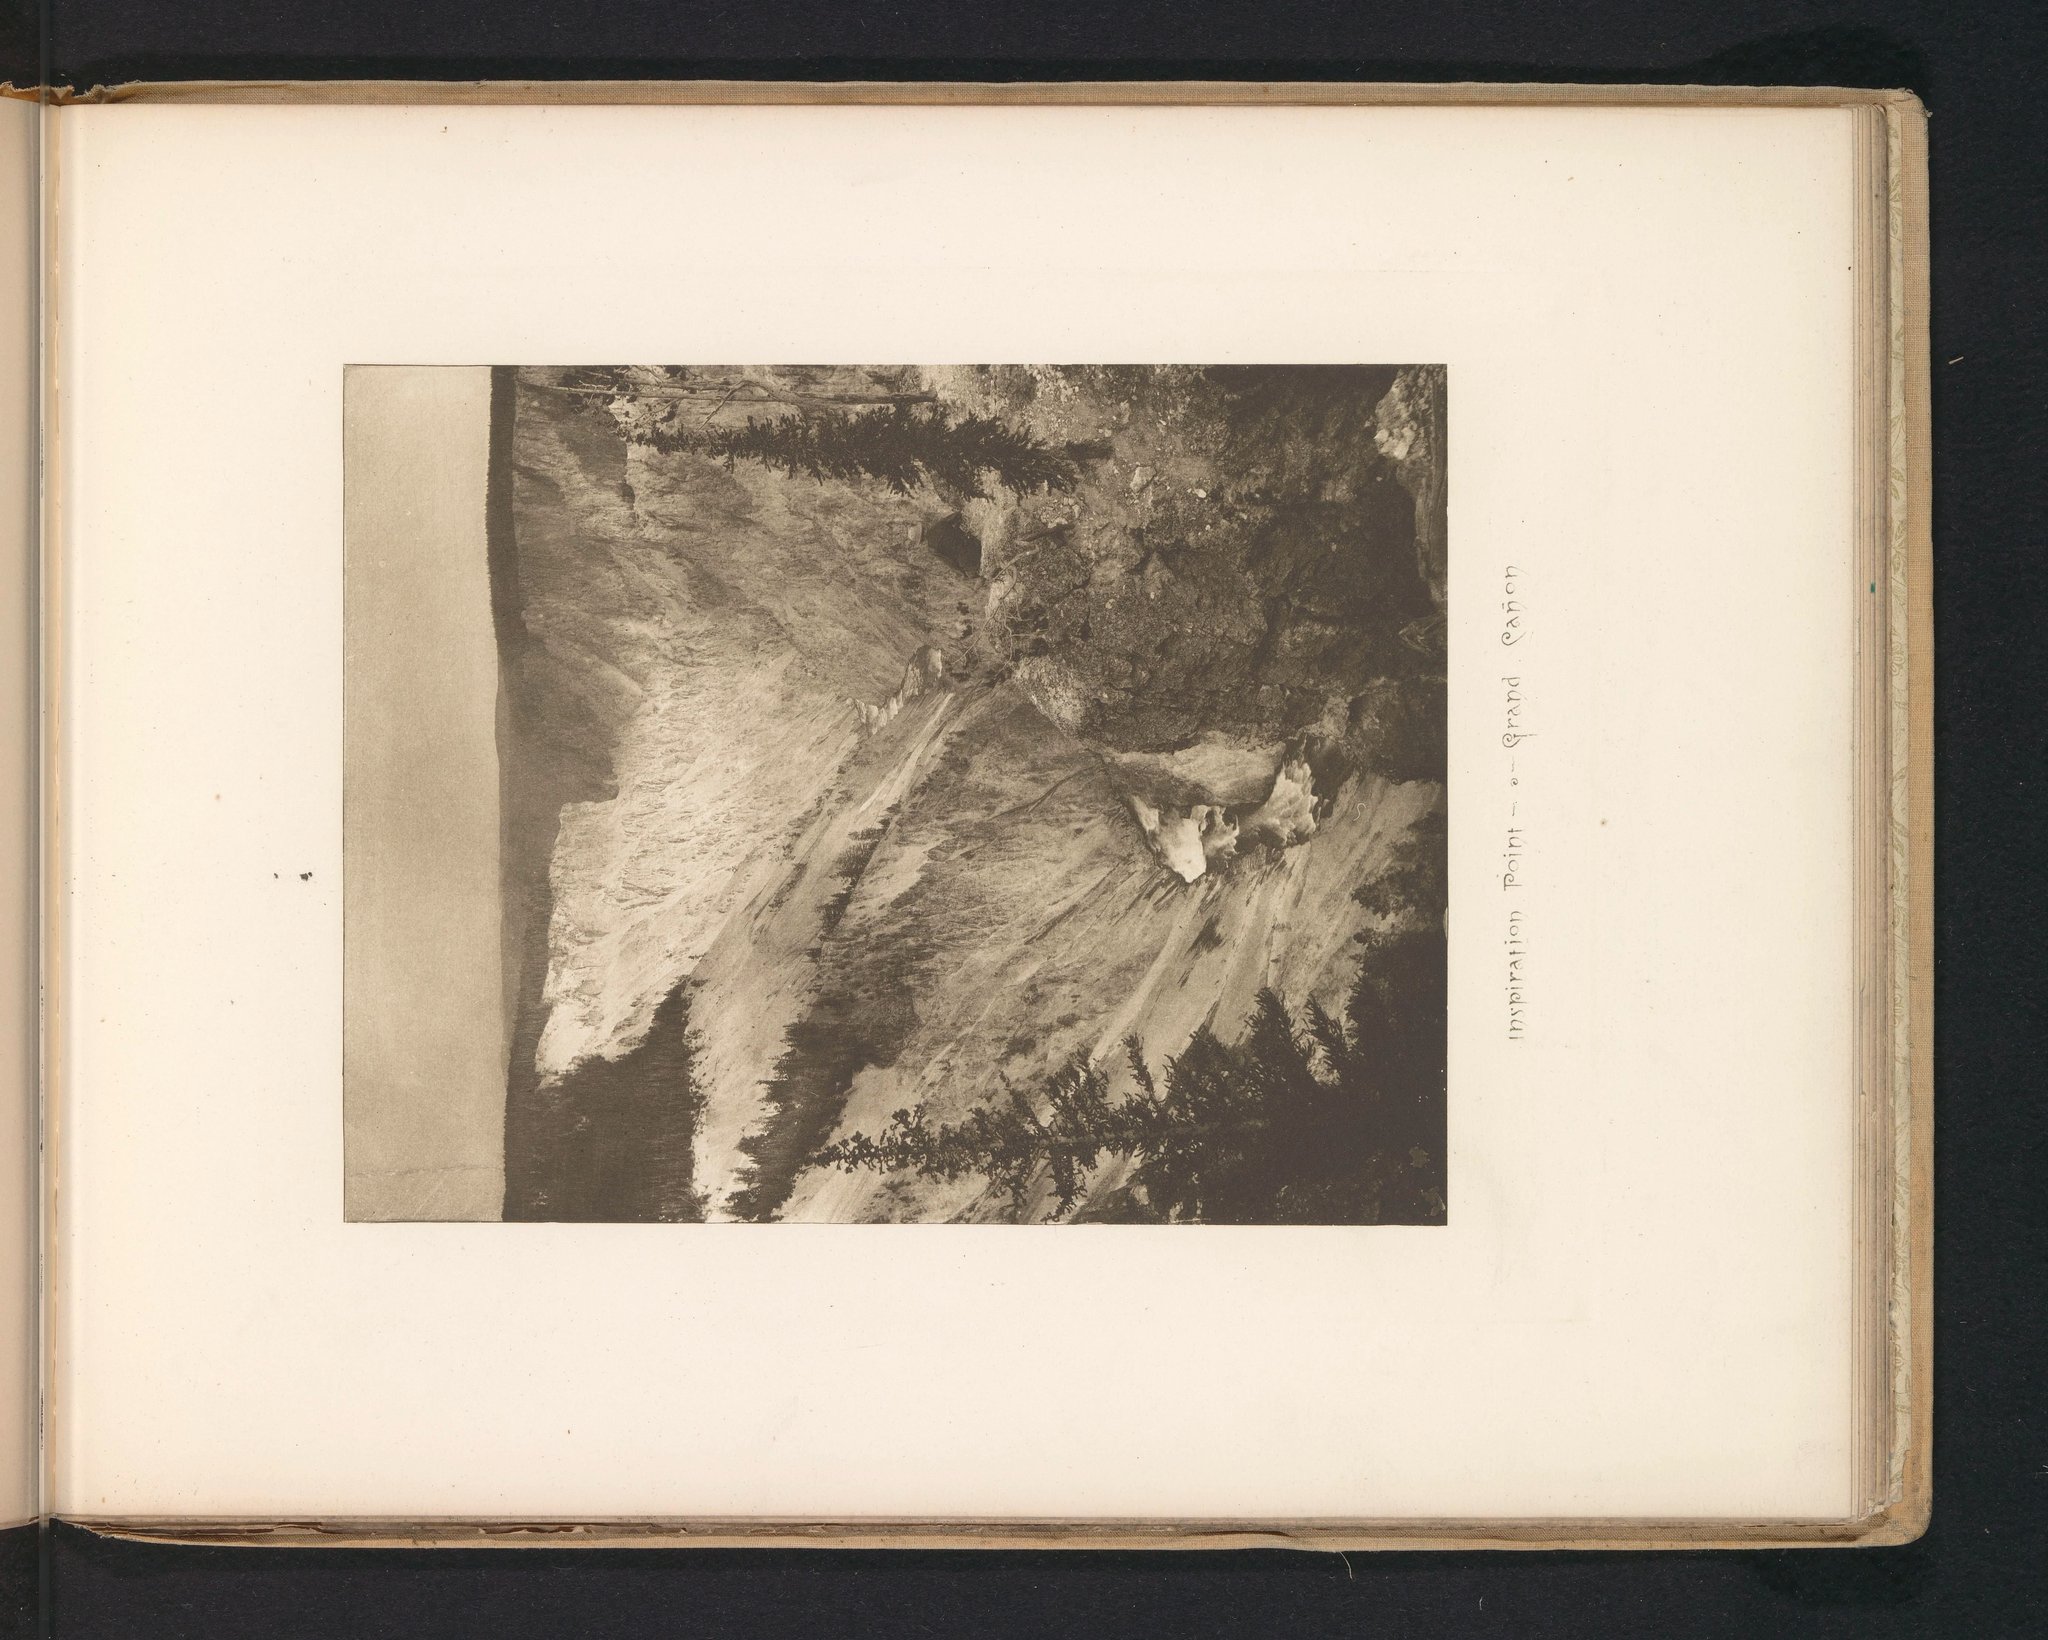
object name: photomechanical print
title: Inspiration point - Grand Cañon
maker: frank jay haynes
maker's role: fotograaf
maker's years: 1853-1921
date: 1882-1887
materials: paper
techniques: photoaquatint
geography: new york city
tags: ravine, chasm, abyss, canyon